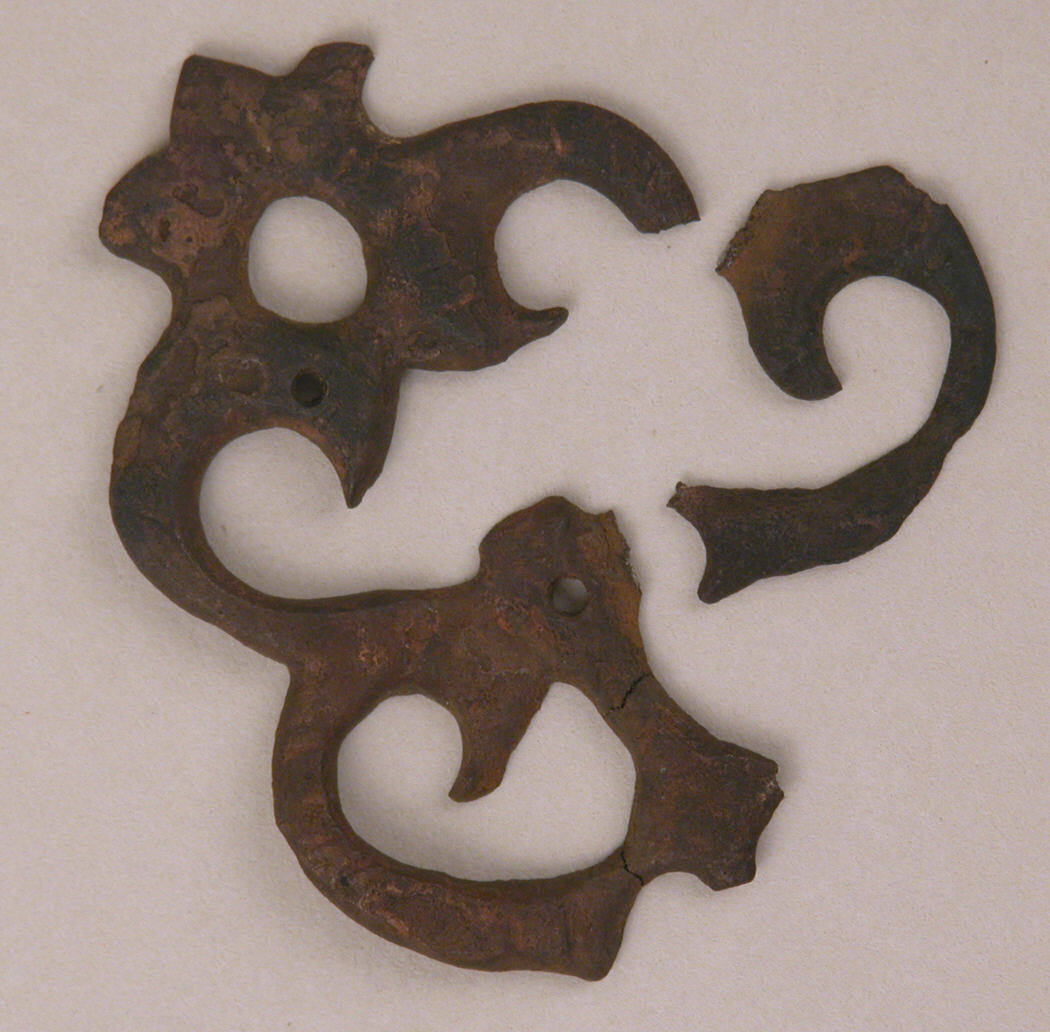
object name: horse harness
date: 901-1100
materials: bronze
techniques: casting, gilding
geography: iran